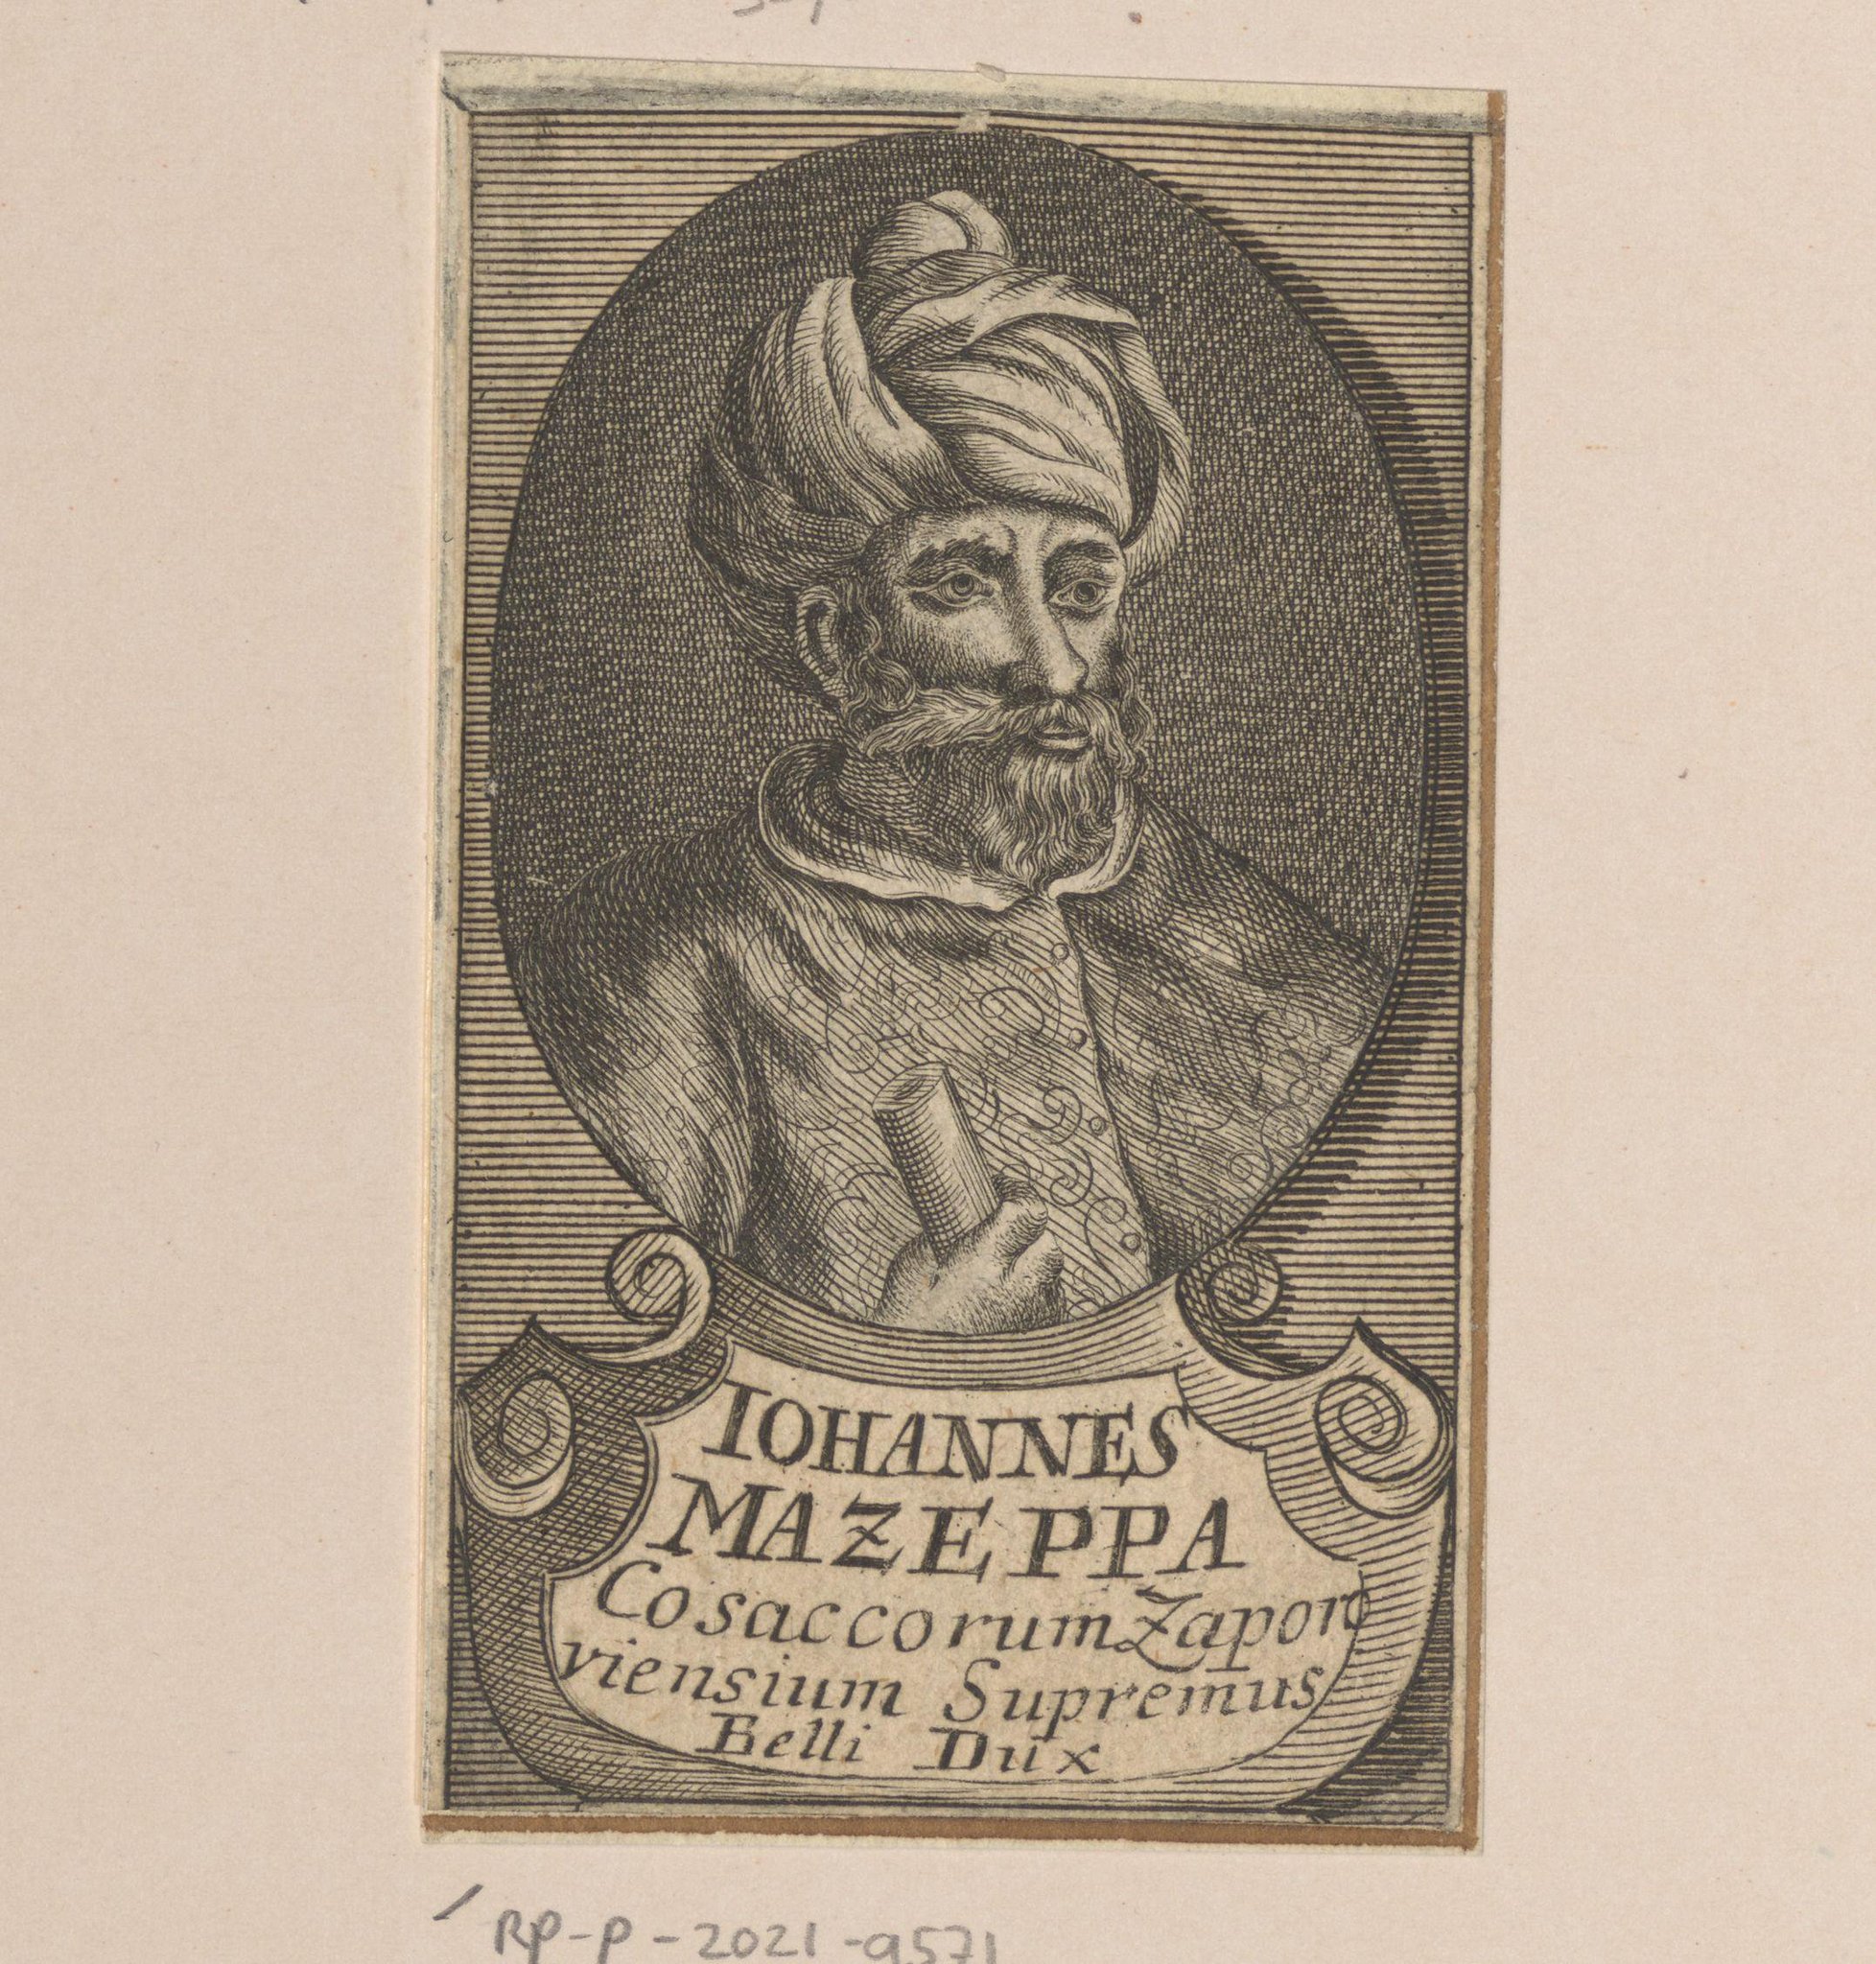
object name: print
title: Portret van Ivan Mazepa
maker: Anonymous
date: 1690-1750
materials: paper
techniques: engraving, etching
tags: commander-in-chief, general, marshal, historical persons, head-gear: turban